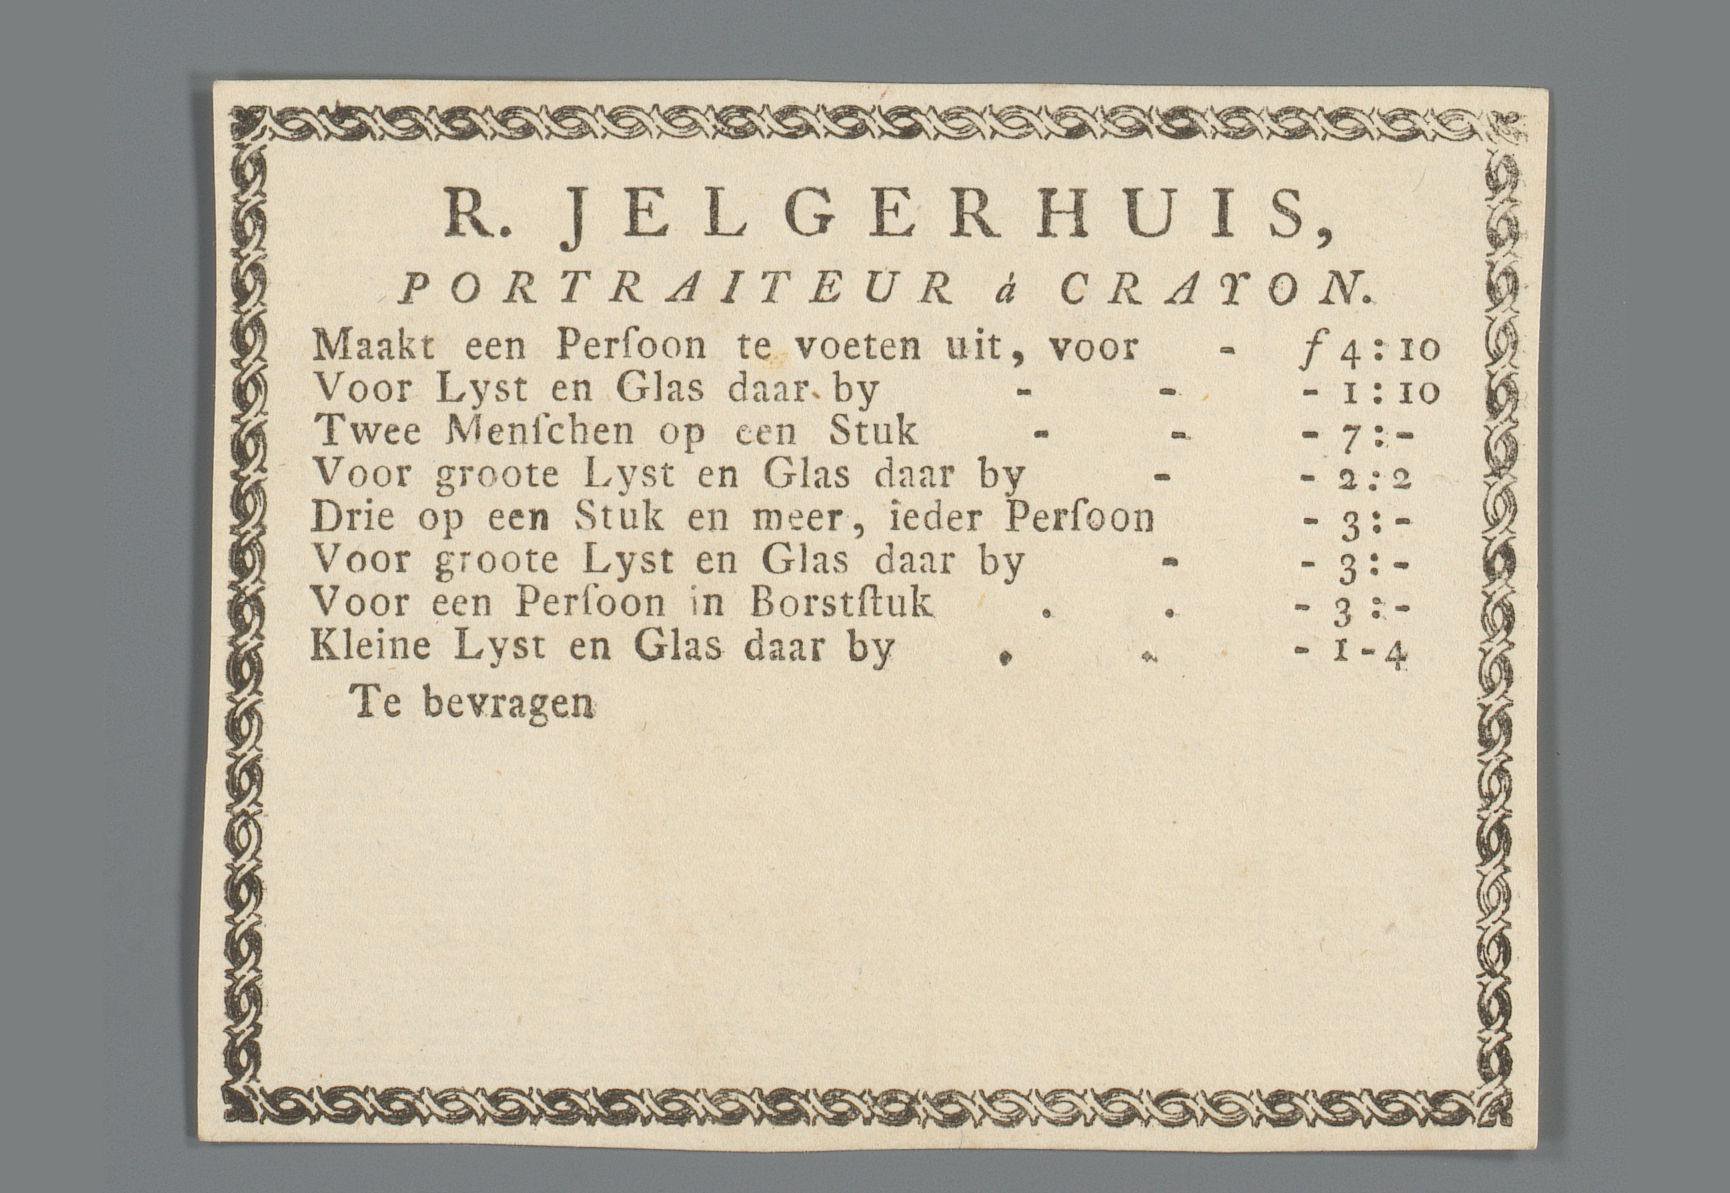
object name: price list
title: Prijslijst van portrettekenaar Rienk Jelgerhuis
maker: Anonymous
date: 1739-1806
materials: paper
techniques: letterpress printing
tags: amsterdam, print maker, draughtsman, rienk jelgerhuis, portrait, self-portrait of artist, printed matter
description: Onder de kop 'R. Jelgerhuis, portraiteur à crayon' volgt een prijslijst voor portretten en bijbehorende lijsten.